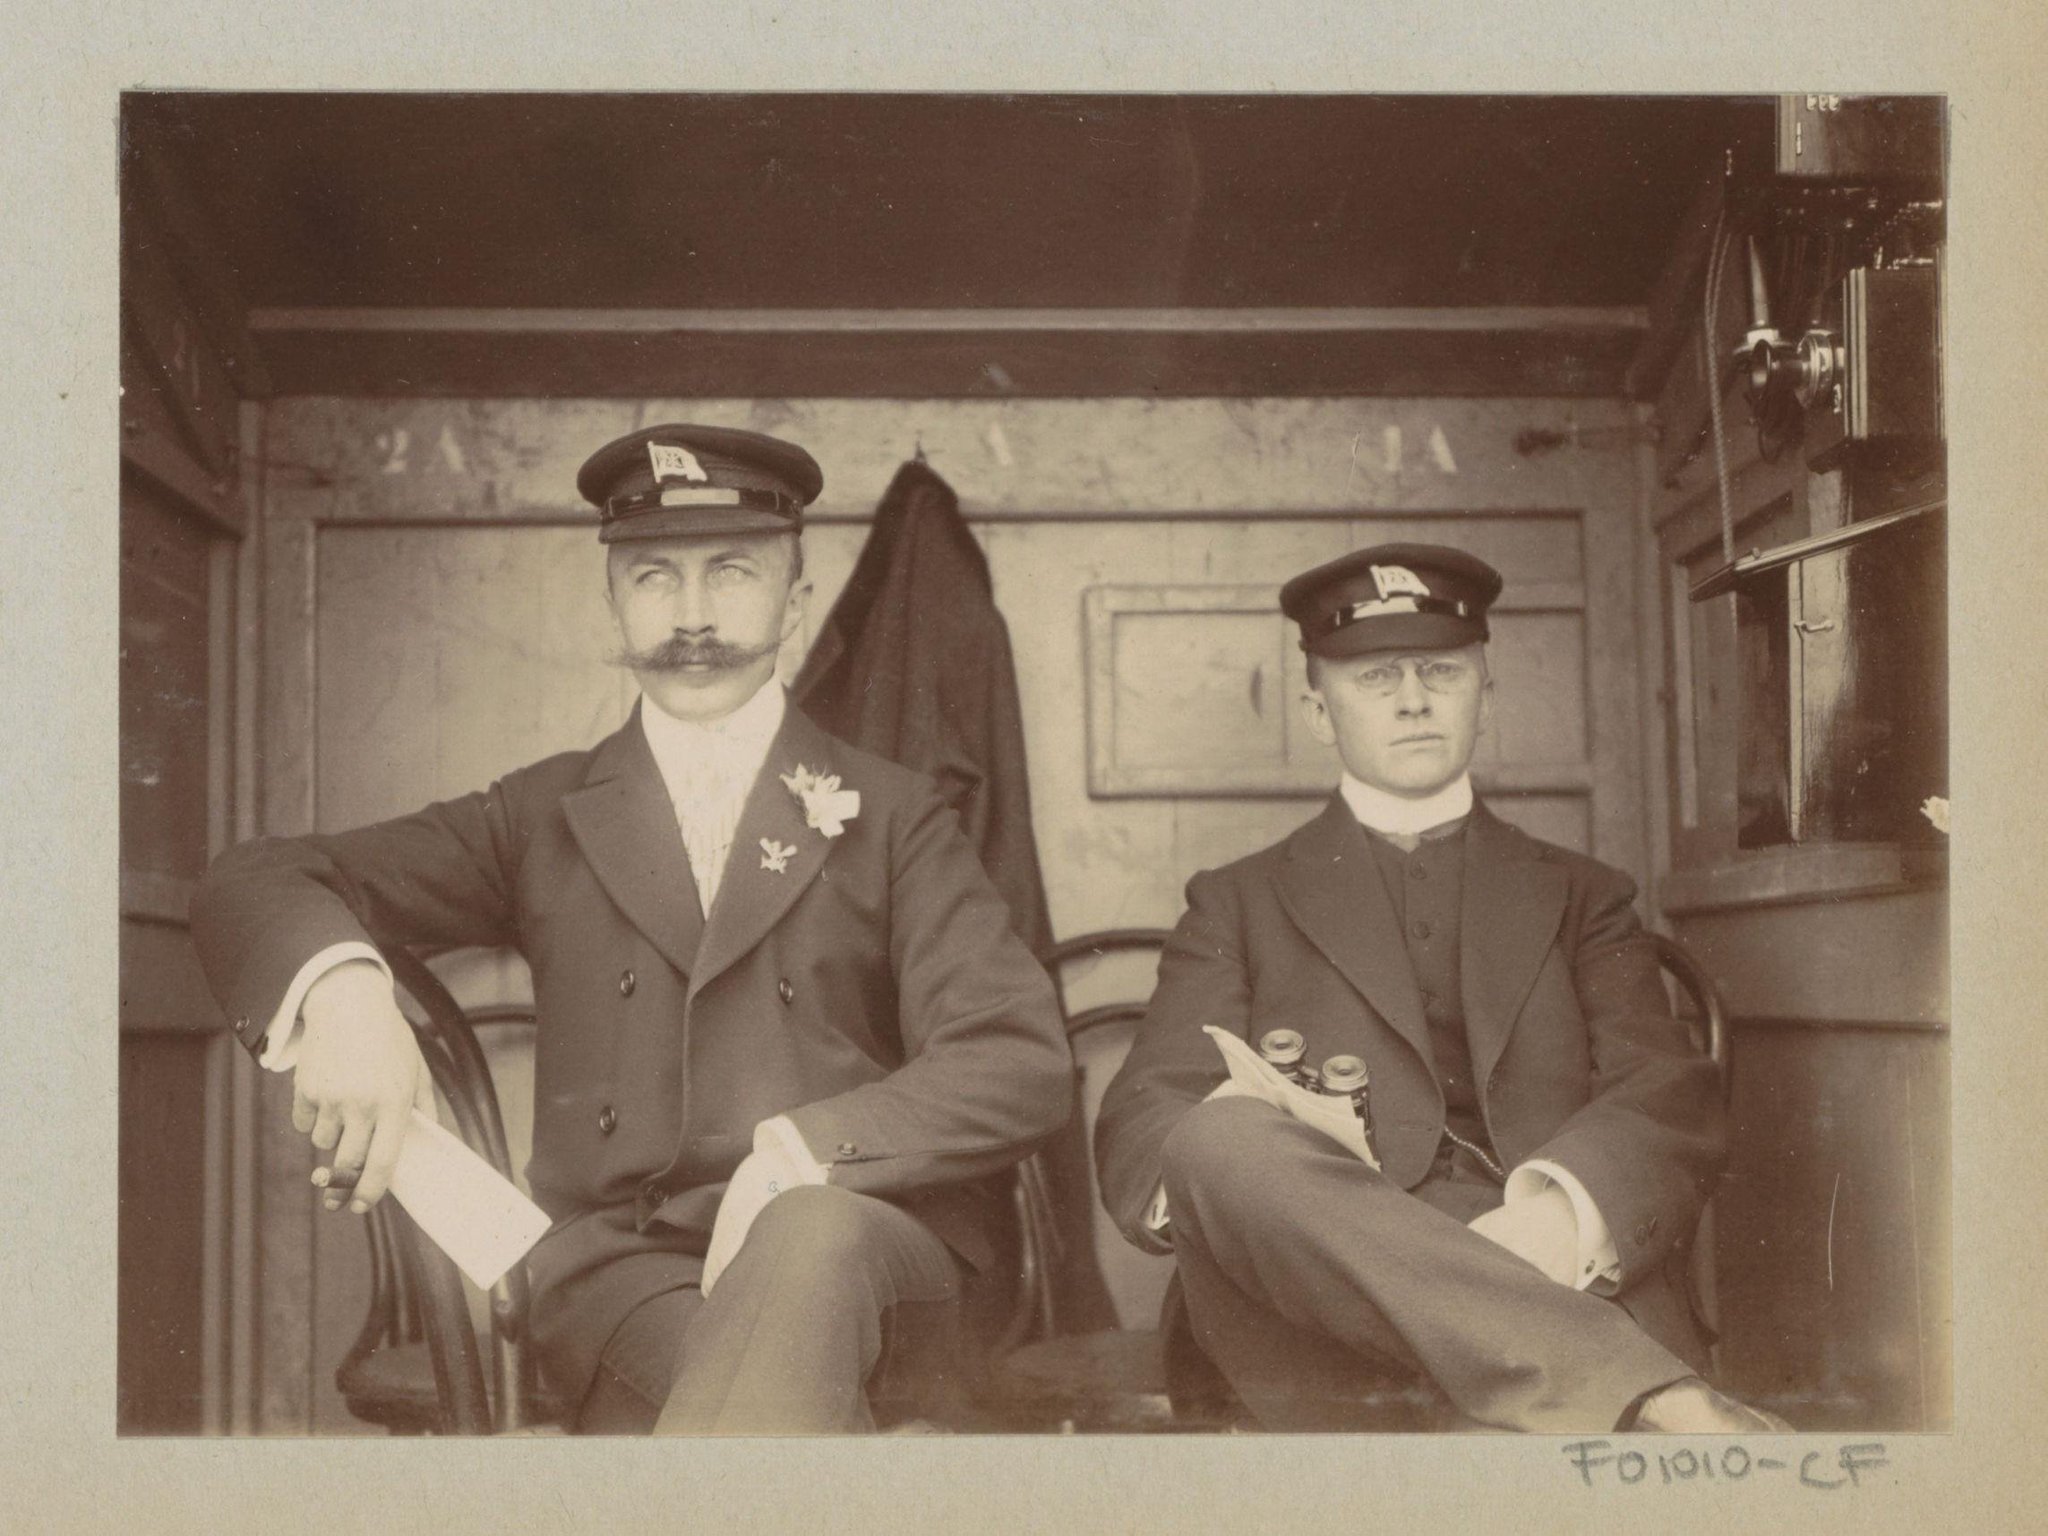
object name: photograph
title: Twee gezagvoerders aan boord van een schip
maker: Anonymous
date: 1906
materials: photographic support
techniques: gelatin silver print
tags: seaman, commemoration, jubilee, amsterdam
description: Foto vermoedelijk genomen tijdens viering van het 25-jarig jubileum (1881-1906) van Roei- en zeilvereniging De Amstel (1881-1906). Onderdeel van Familiealbum met onder meer foto's van Wijnhandel Kraaij & Co. Bordeaux-Amsterdam.